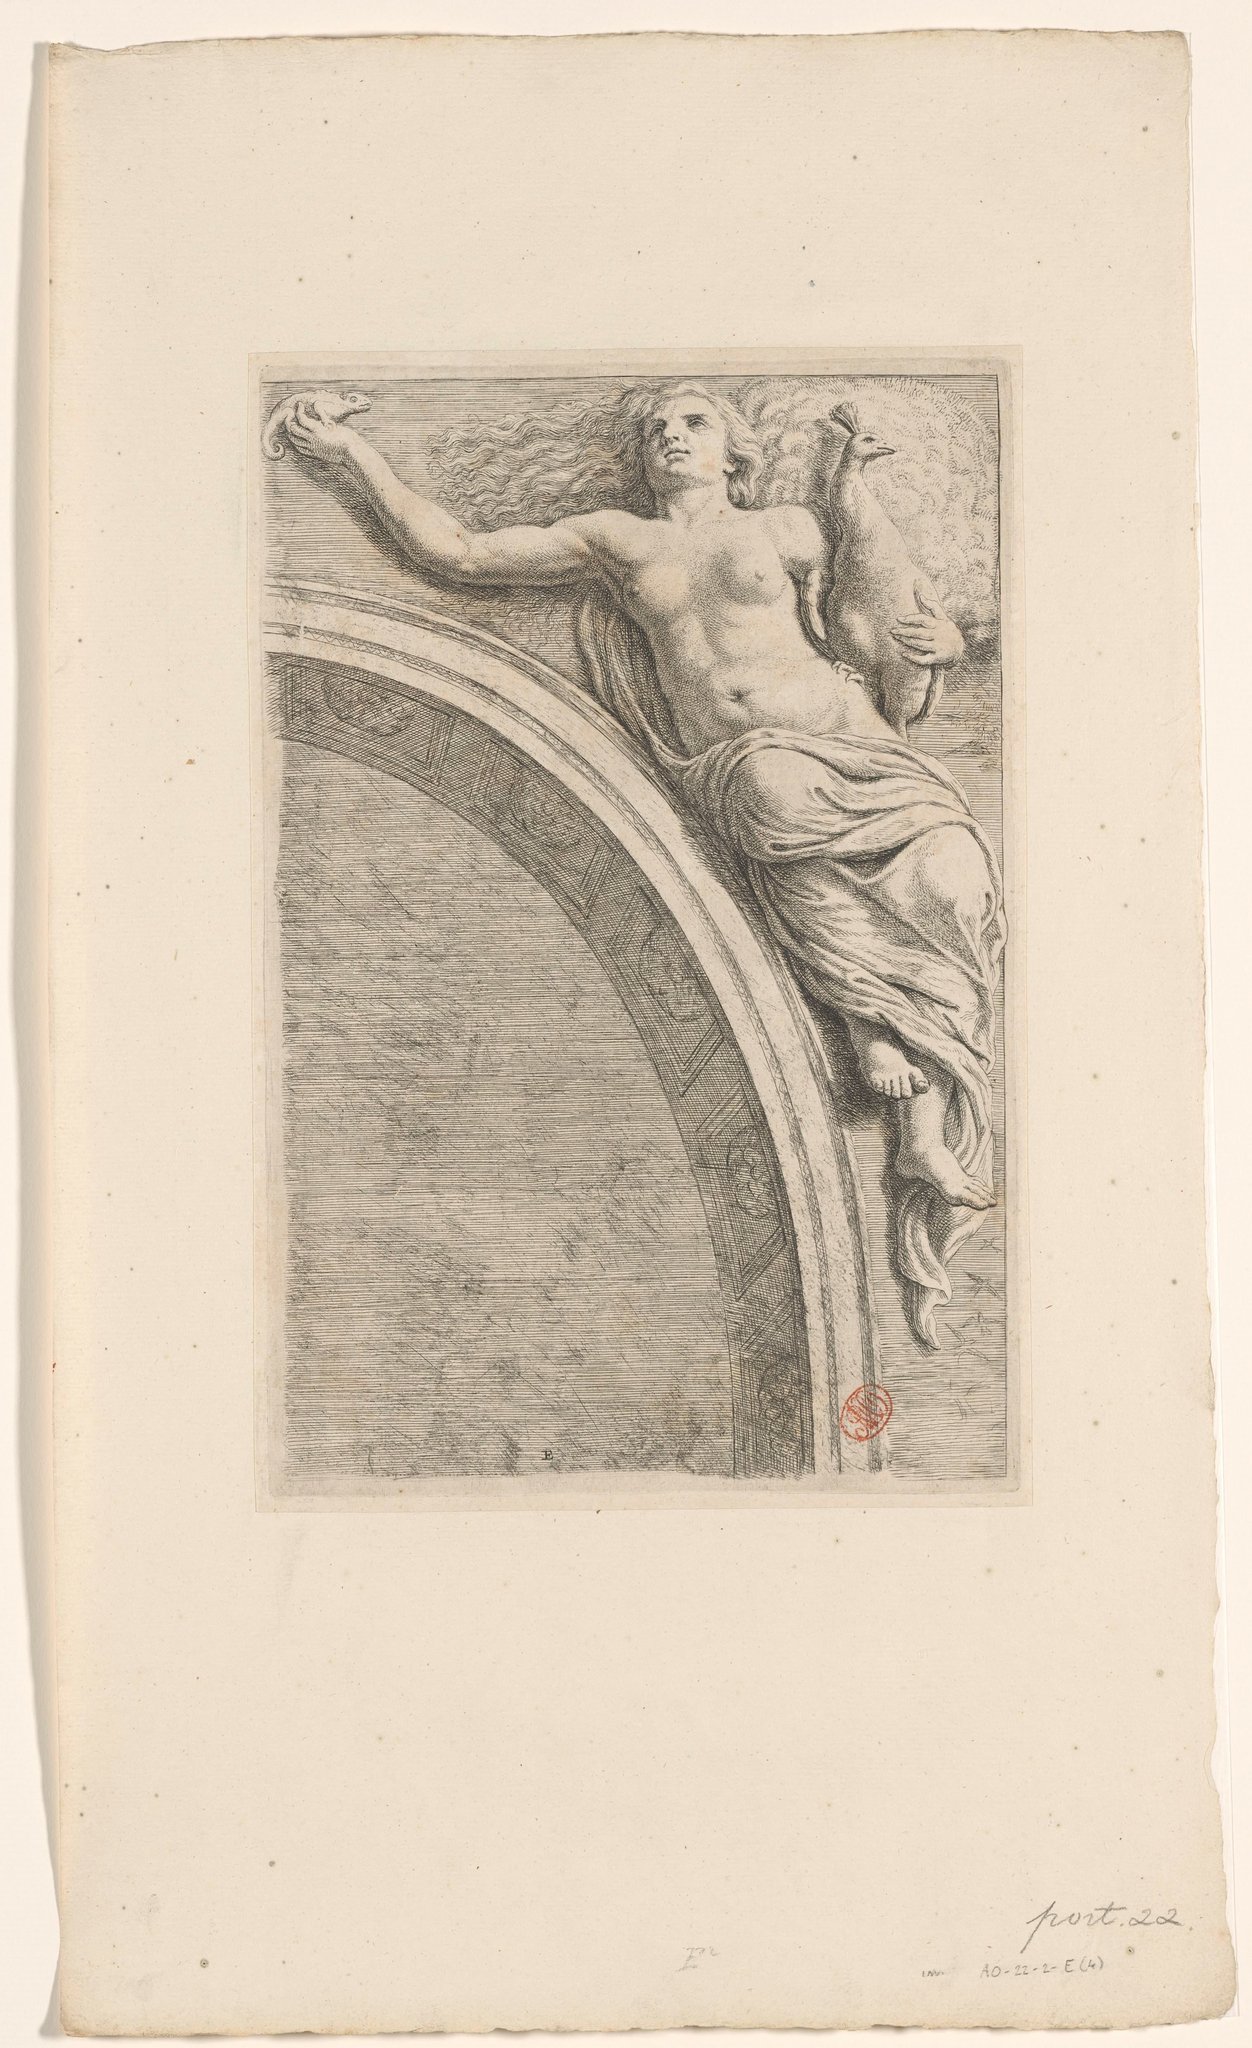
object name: book illustration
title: Reliëf met personificatie van het element Lucht boven boog aan westzijde van de Burgerzaal in het Stadhuis op de Dam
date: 1663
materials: paper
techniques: engraving, etching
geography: amsterdam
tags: air (one of the four elements), ornamental birds: peacock, lizards: chameleon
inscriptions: collector's mark: Lugt 195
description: Prent gebruikt in: Secunca pars Praecipuarum effigierum ac ornamentorum amplissime Curiae Amstelrodamensis maiori ex parte in cadido marmore effectorum per Artum Quellinium eiusdem Civitatis Statuarium / Het tweede deel Van de voornaemste Statuen ende Cieraten van 't konst-rijcke Stadt-huys van Amstelredam 'tmeeste in Marmer gemaeckt door Artus Quellinus Beelthouwer der voorseyde Stadt. Amsterdam: Artus Quellinus (I), 1663. Zie RP-P-AO-22-2-1 voor bijhorende titelpagina. Zie RP-P-AO-22-2-2 voor bijhorend register. Zie RP-P-AO-22-2A, RP-P-AO-22-2B, RP-P-AO-22-2C-1, RP-P-AO-22-2C-2, RP-P-AO-22-2C-3, RP-P-AO-22-2C-4, RP-P-AO-22-2D-1, RP-P-AO-22-2D-2, RP-P-AO-22-2D-3, RP-P-AO-22-2E-1, RP-P-AO-22-2E-2, RP-P-AO-22-2E-3, RP-P-AO-22-2F-1, RP-P-AO-22-2F-2, RP-P-AO-22-2F-3, RP-P-AO-22-2G, RP-P-AO-22-2H, RP-P-AO-22-2I, RP-P-AO-22-2K, RP-P-AO-22-2L, RP-P-AO-22-2M, RP-P-AO-22-2N, RP-P-AO-22-2O-1, RP-P-AO-22-2O-2, RP-P-AO-22-2O-3, RP-P-AO-22-2O-4, RP-P-AO-22-2O-5, RP-P-AO-22-2O-6, RP-P-AO-22-2O-7, RP-P-AO-22-2P-1, RP-P-AO-22-2P-2, RP-P-AO-22-2Q-1, RP-P-AO-22-2Q-2, RP-P-AO-22-2Q-3, RP-P-AO-22-2R-1, RP-P-AO-22-2R-2, RP-P-AO-22-2R-3, RP-P-AO-22-2S, RP-P-AO-22-2T-1, RP-P-AO-22-2T-2, RP-P-AO-22-2T-3, RP-P-AO-22-2T-4, RP-P-AO-22-2V-1, RP-P-AO-22-2V-2, RP-P-AO-22-2W-1, RP-P-AO-22-2W-2, RP-P-AO-22-2X-1, RP-P-AO-22-2X-2 en RP-P-AO-22-2X-3 voor andere prenten uit deze publicatie. Zelfde staat van prent ook gebruikt in: Secunca pars Praecipuarum effigierum ac ornamentorum amplissime Curiae Amstelrodamensis maiori ex parte in cadido marmore effectorum per Artum Quellinium eiusdem Civitatis Statuarium / Het tweede deel Van de voornaemste Statuen ende Cieraten van 't konst-rijcke Stadt-huys van Amstelredam 'tmeeste in Marmer gemaeckt door Artus Quellinus Beelthouwer der voorseyde Stadt. Amsterdam: Frederik de Wit, 1668. Latere staat van prent ook gebruikt in: Architecture peinture et sculpture de la Maison de Ville d'Amsterdam, representee en CIX. figures en taille-douce (…). Amsterdam: David Mortier, 1719. En in: Architecture peinture et sculpture de la Maison de Ville d'Amsterdam, representee en CIX. figures en taille-douce (…). Amsterdam: Gerard Valck, 1719. En in: Bouw schilder en beeldhouwkonst, van het Stadhuis te Amsteldam, vertoont in CIX figuuren (…). Amsterdam: Covens & Mortier & Covens Jr., s.a. (1774-1783).